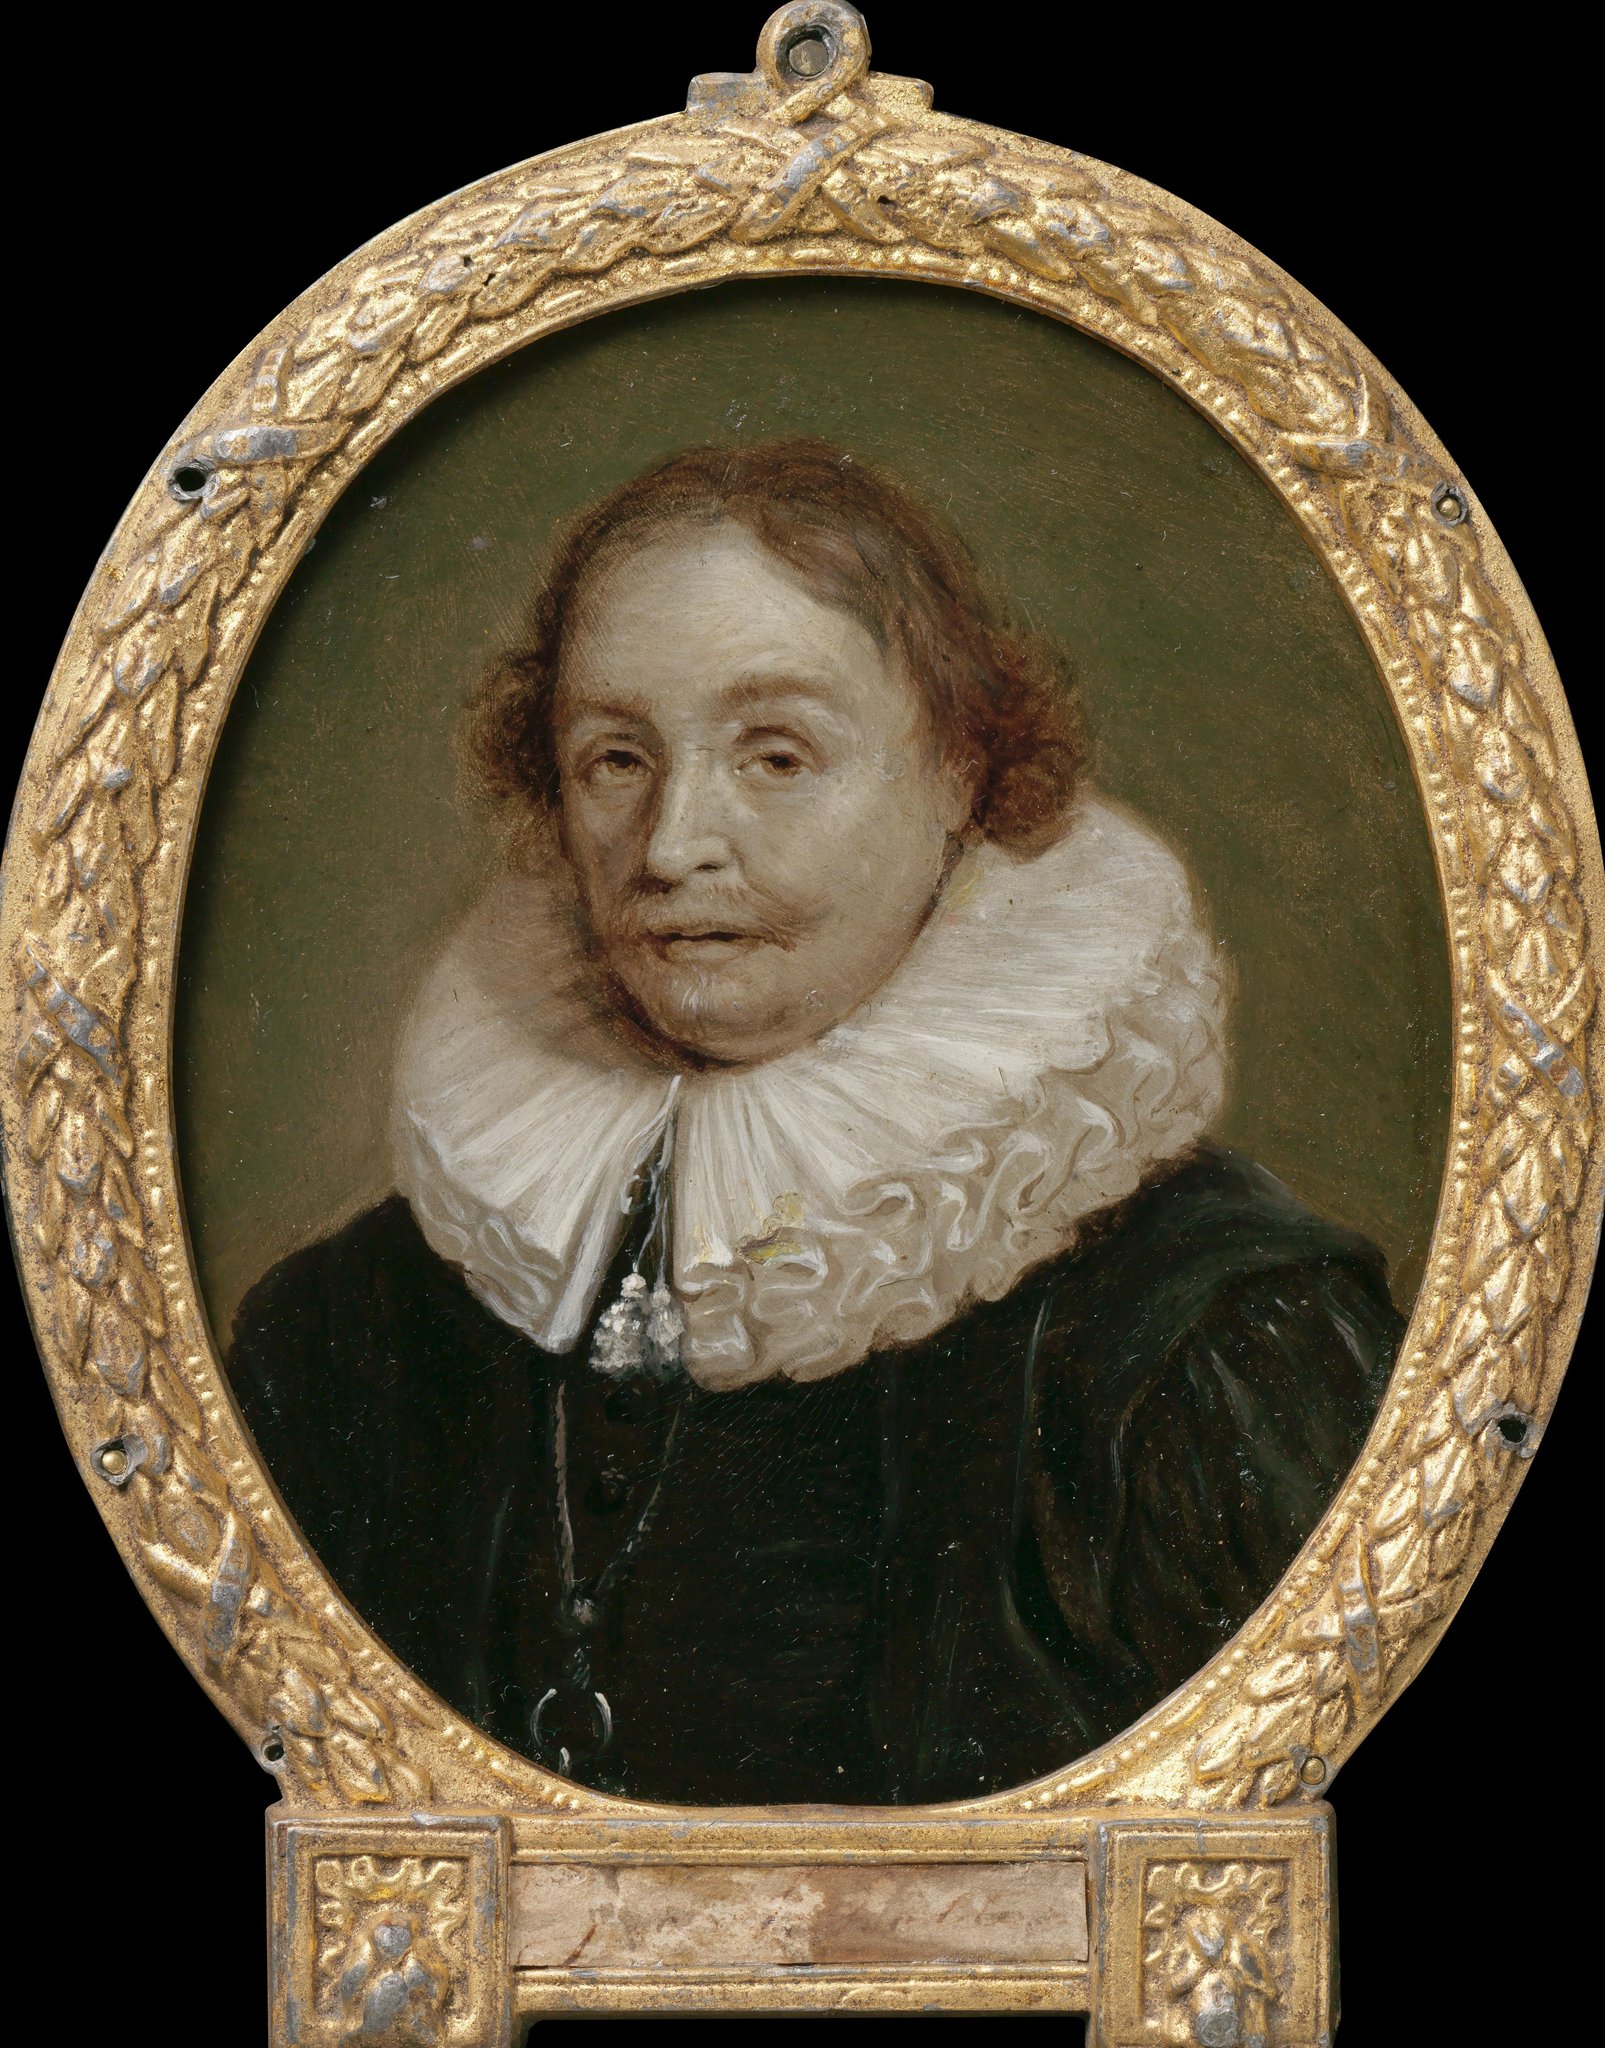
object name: grisaille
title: Portrait of Pierius Winsemius, Professor of Rhetoric and History in Franeker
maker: jan maurits quinkhard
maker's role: draughtsman, painter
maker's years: 1688-1772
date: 1732-1771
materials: copper, oil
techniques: grisaille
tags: pier winsemius, historical persons, professor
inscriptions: inscription: ‘Pierius Winsemius. Aº 1586’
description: Portret van Piërius Winsemius (1586-1641). Hoogleraar in de welsprekendheid en de geschiedenis te Franeker. Buste in ovaal naar links. Onderdeel van een verzameling portretten van Nederlandse dichters.